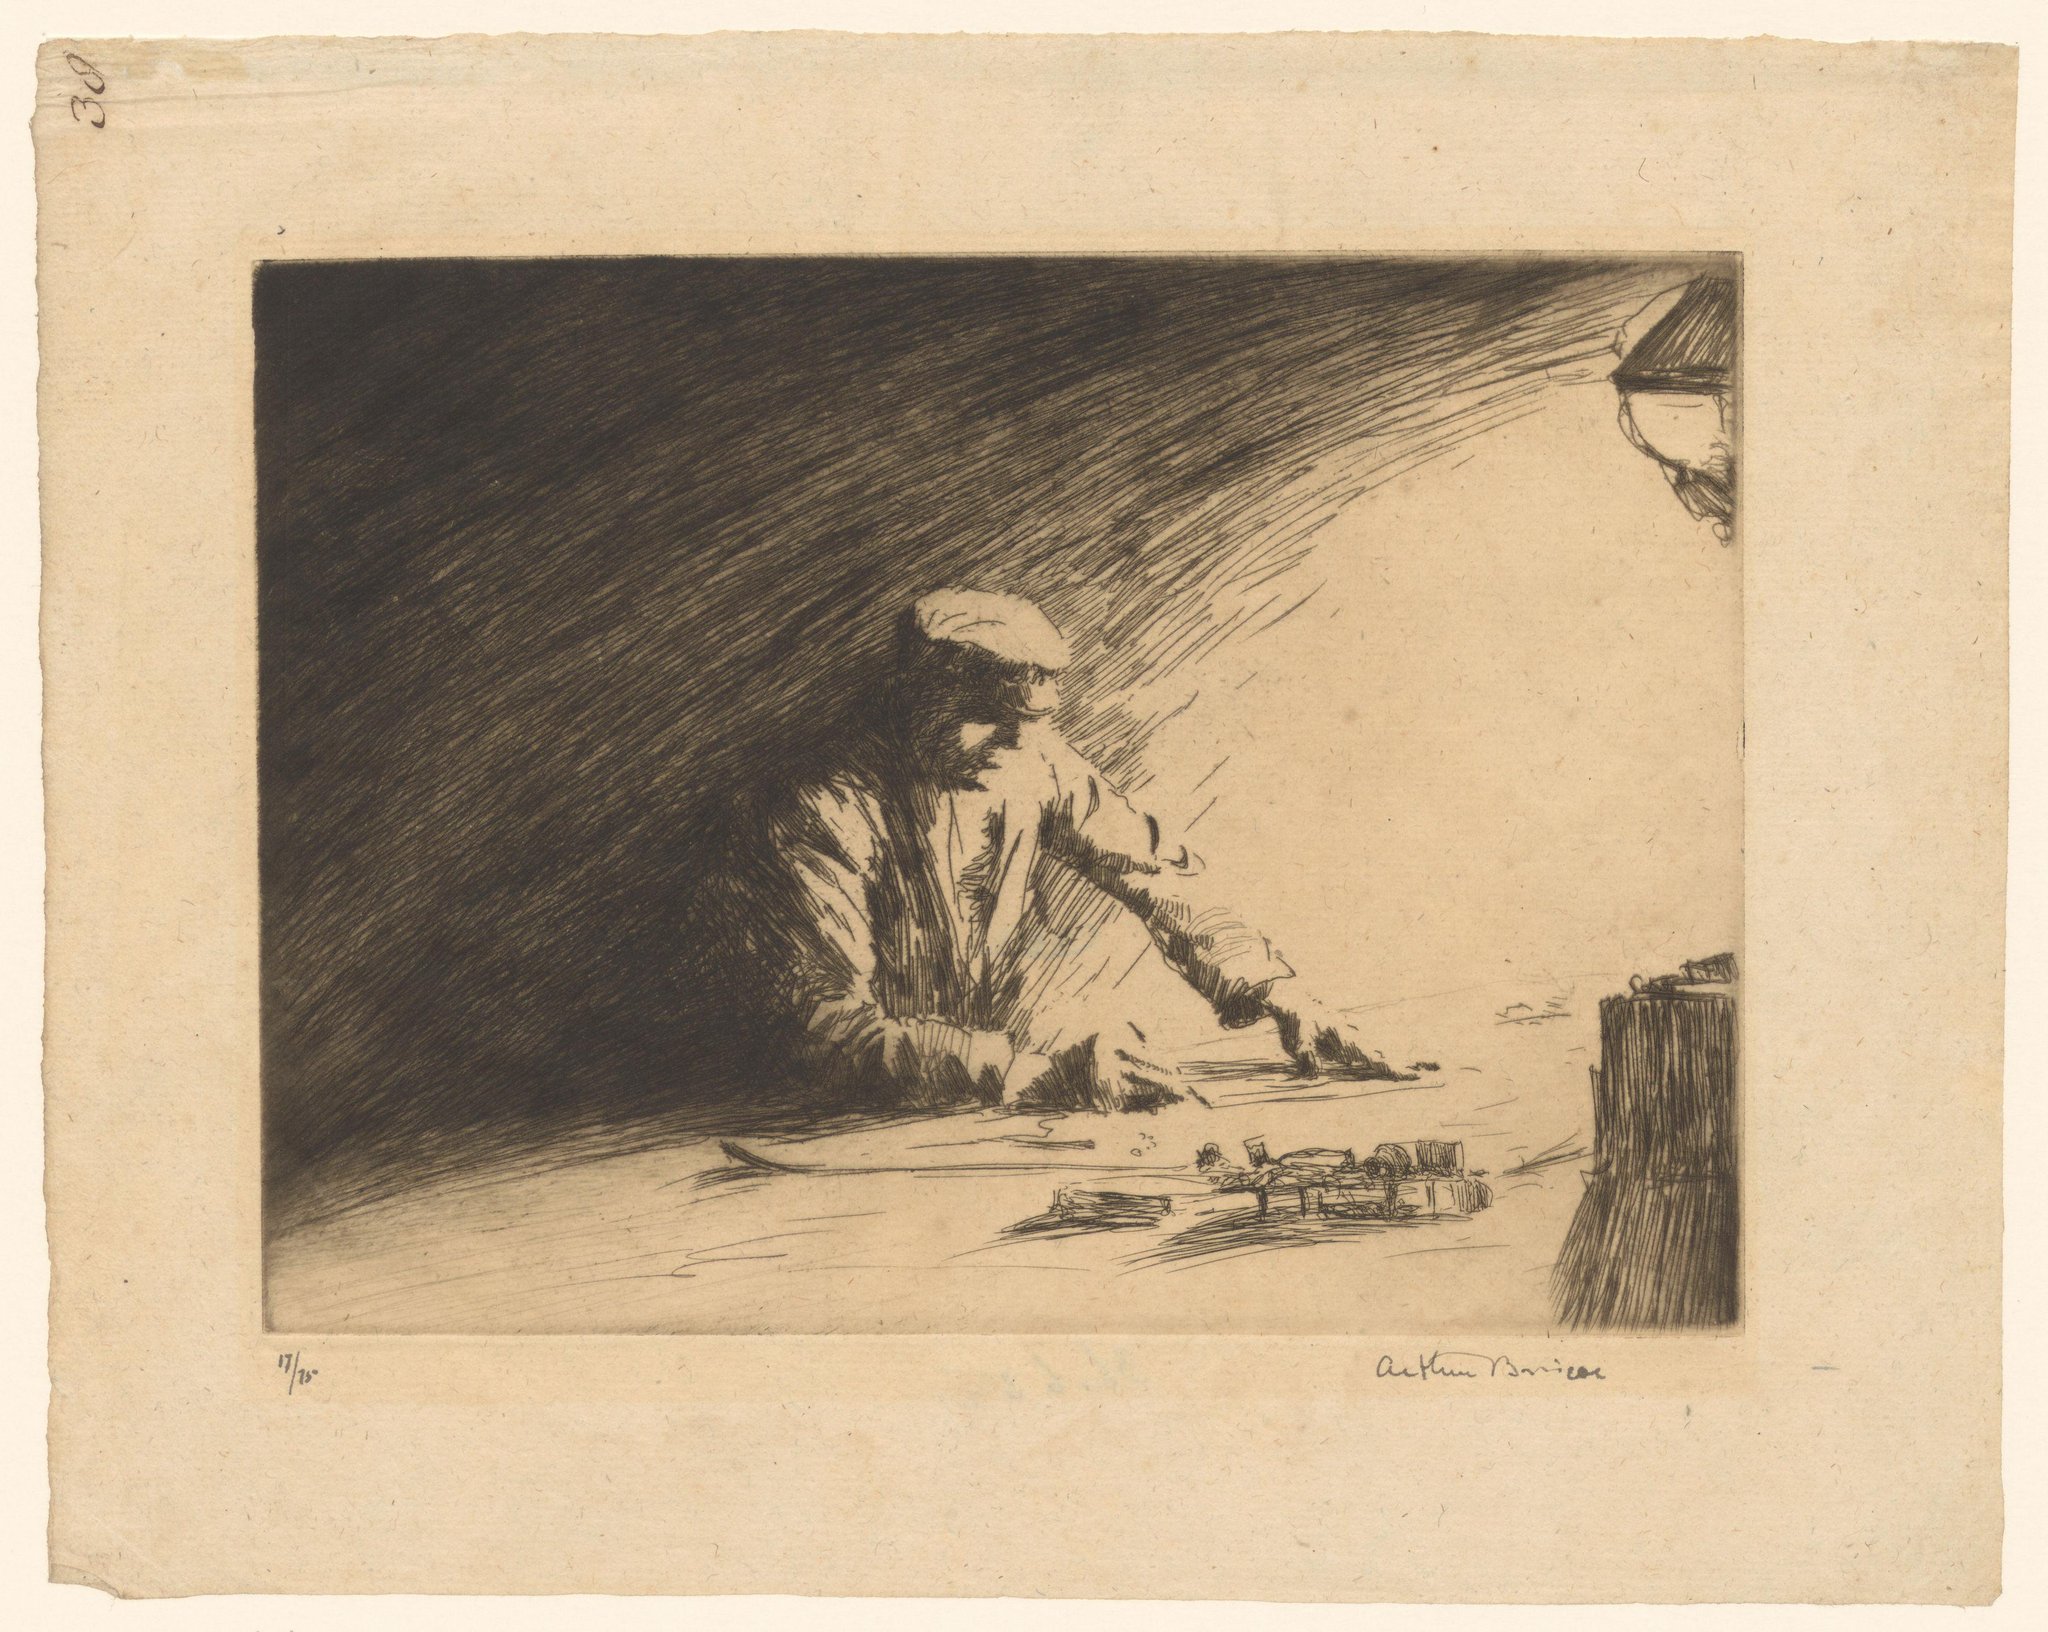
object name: print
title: The Old Man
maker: arthur john trevor briscoe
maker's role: print maker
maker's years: 1873-1943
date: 1925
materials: paper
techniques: drypoint, etching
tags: handwriting, writing as activity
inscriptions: collector's mark: Lugt 2228